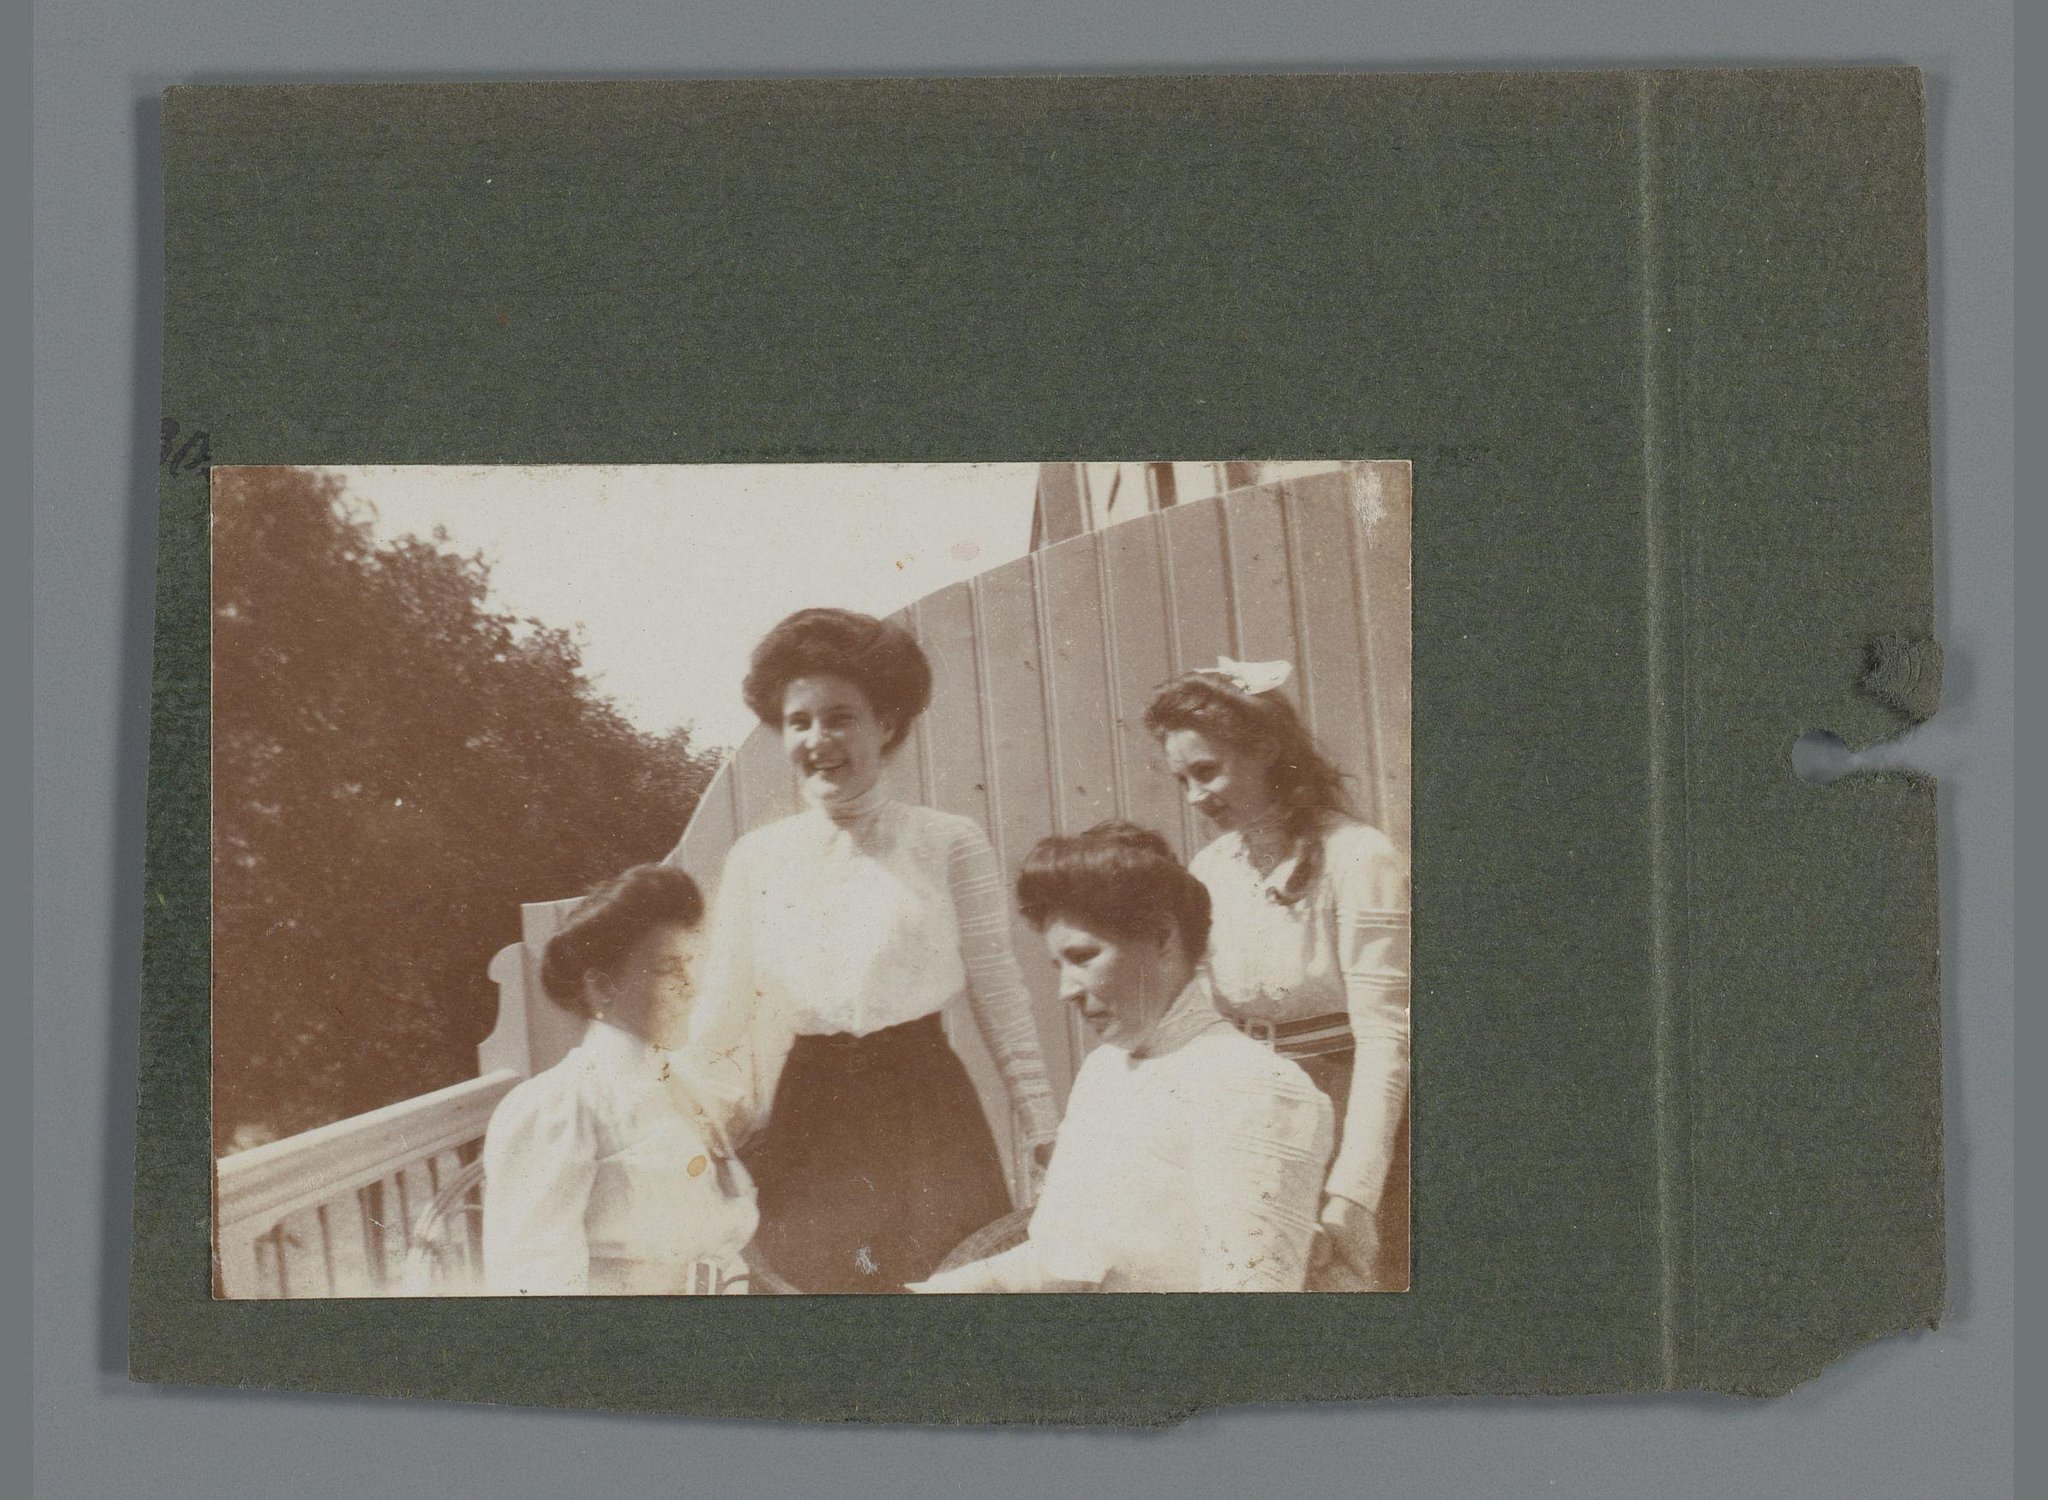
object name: photograph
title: Johanna (Hans) de Jong met Elisabeth de Jong, Johanna (Nan) Vreede en een onbekende vrouw op een balkon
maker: willem de jong (fotograaf)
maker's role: arts, fotograaf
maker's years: 1864-1918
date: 1905-1910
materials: paper, cardboard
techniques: collodion silver print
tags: haarlem, elisabeth de jong-van tonderen, leiden, johanna petronella lambertina stokhuyzen-de jong (hans), surabaya, johanna elisabeth borgerhoff mulder-vreede (nan), historical persons - bb - woman, historical persons not known by name - bb - woman, balcony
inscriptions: number: ‘30.’